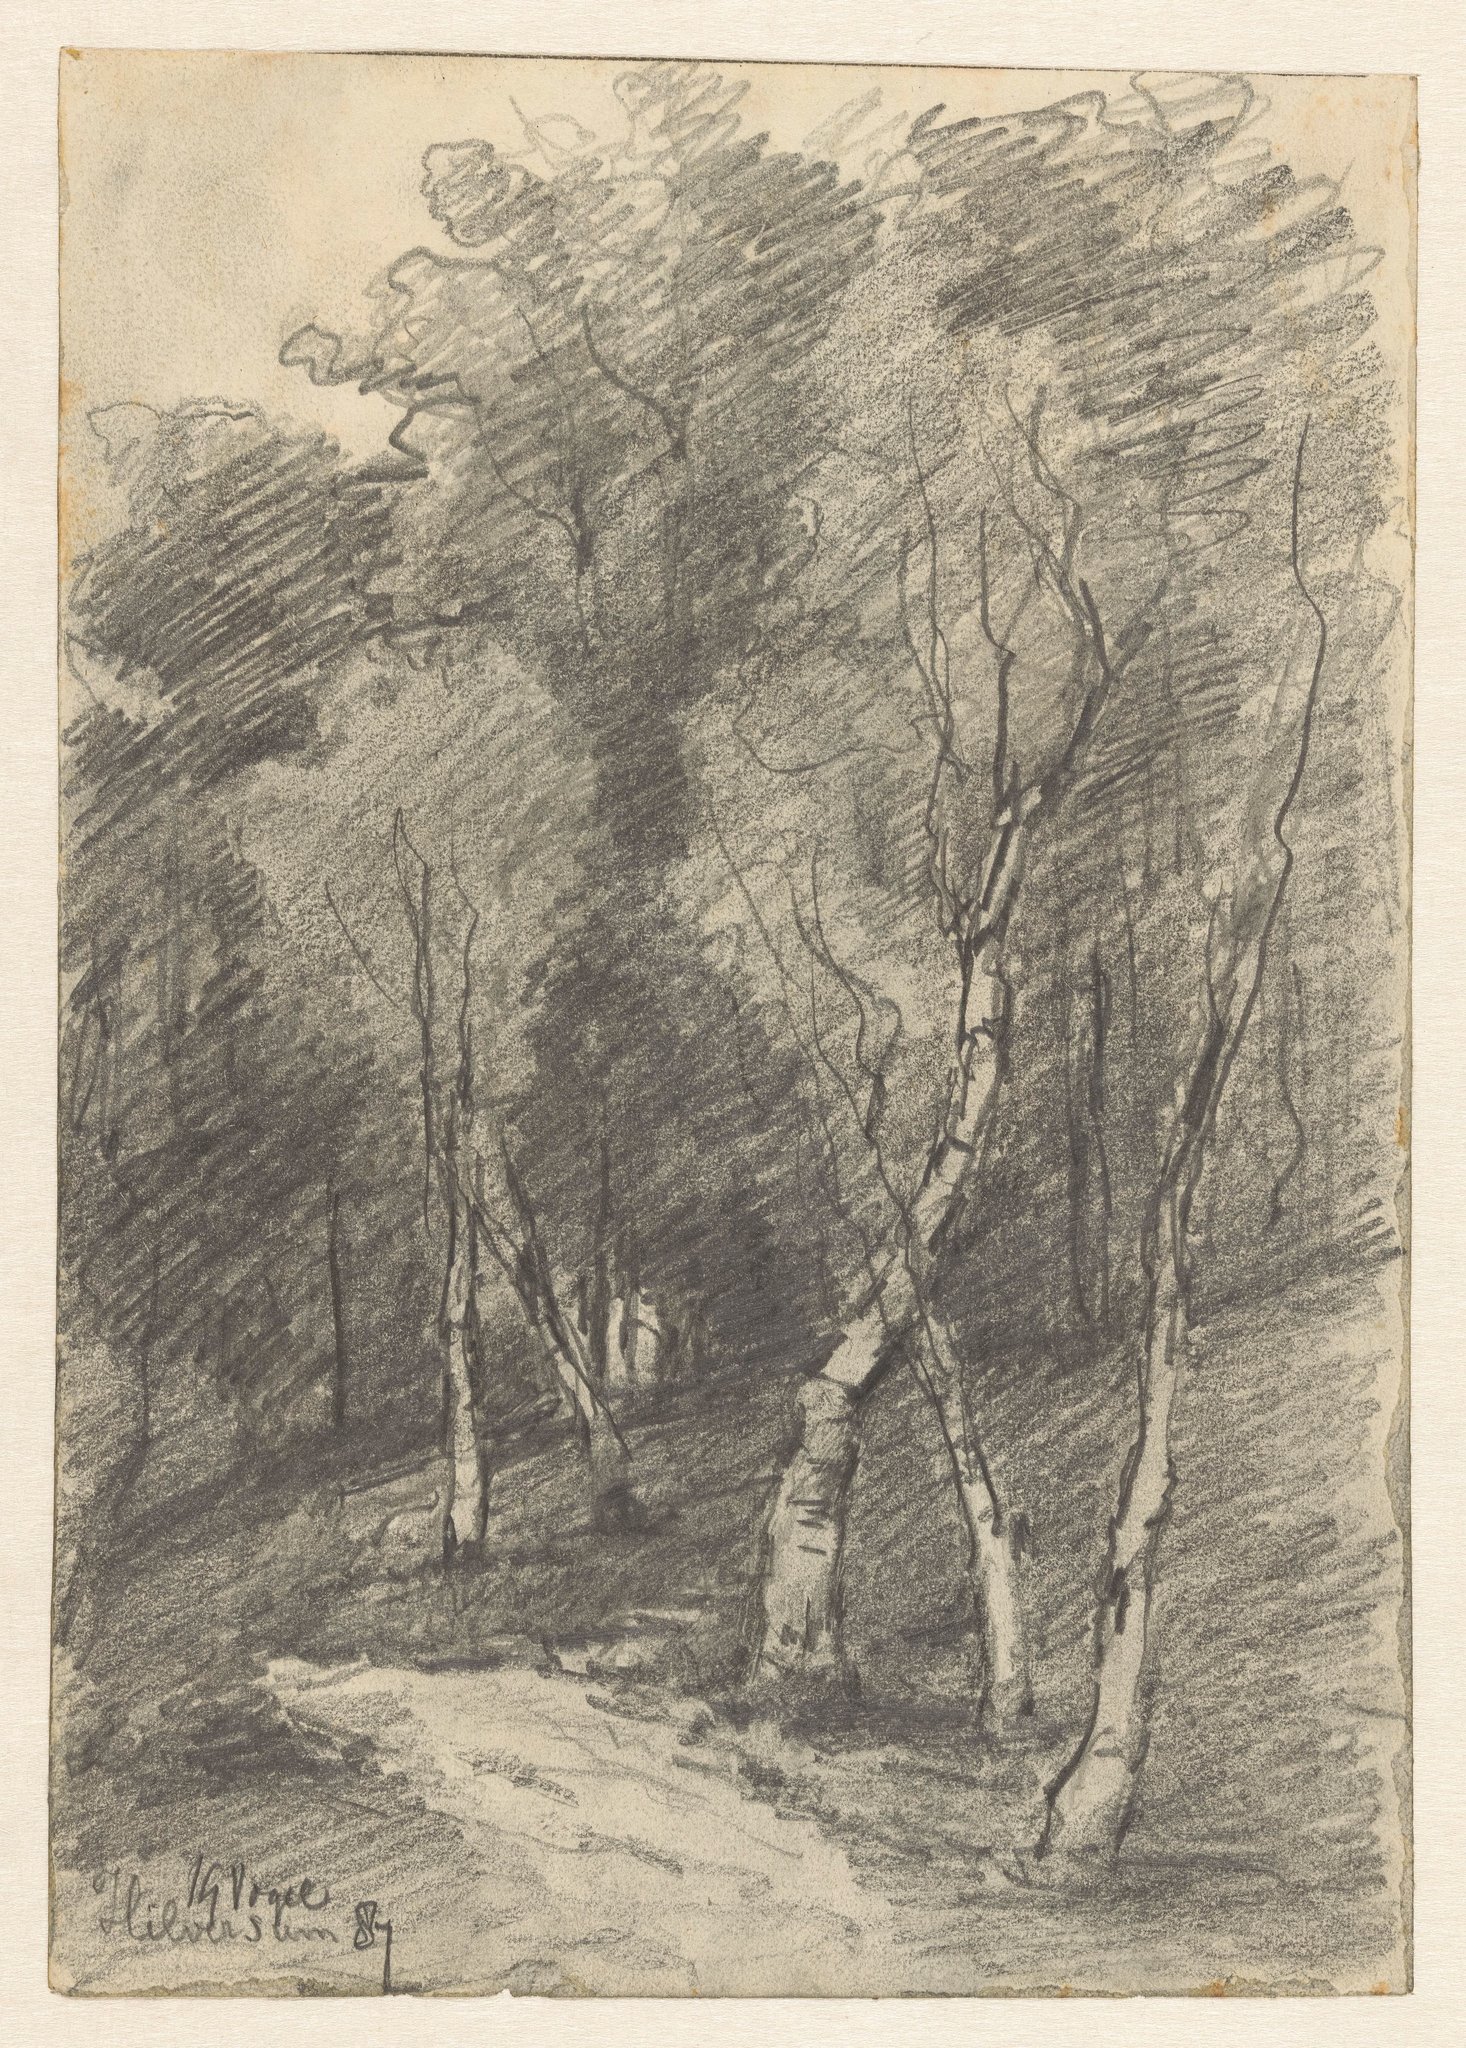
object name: drawing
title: Boslandschap bij Hilversum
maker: johannes gijsbert vogel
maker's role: draughtsman, painter, print maker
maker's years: 1828-1915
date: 1887-1888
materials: chalk, paper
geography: hilversum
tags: forest, wood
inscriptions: date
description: Boslandschap bij Hilversum; verso: Heidelandschap.